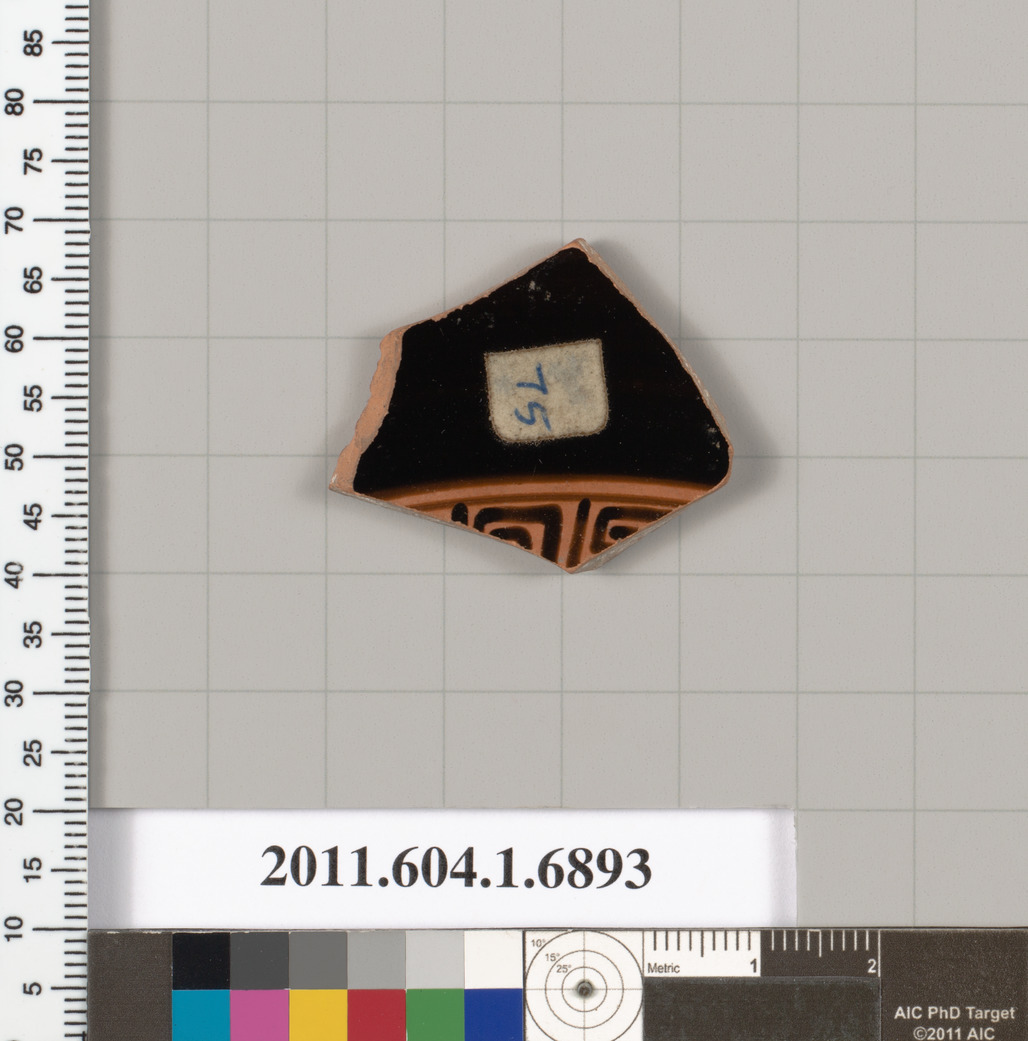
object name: kylix fragment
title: Terracotta fragment of a kylix (drinking cup)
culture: greek, attic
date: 490-470 BCE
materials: terracotta